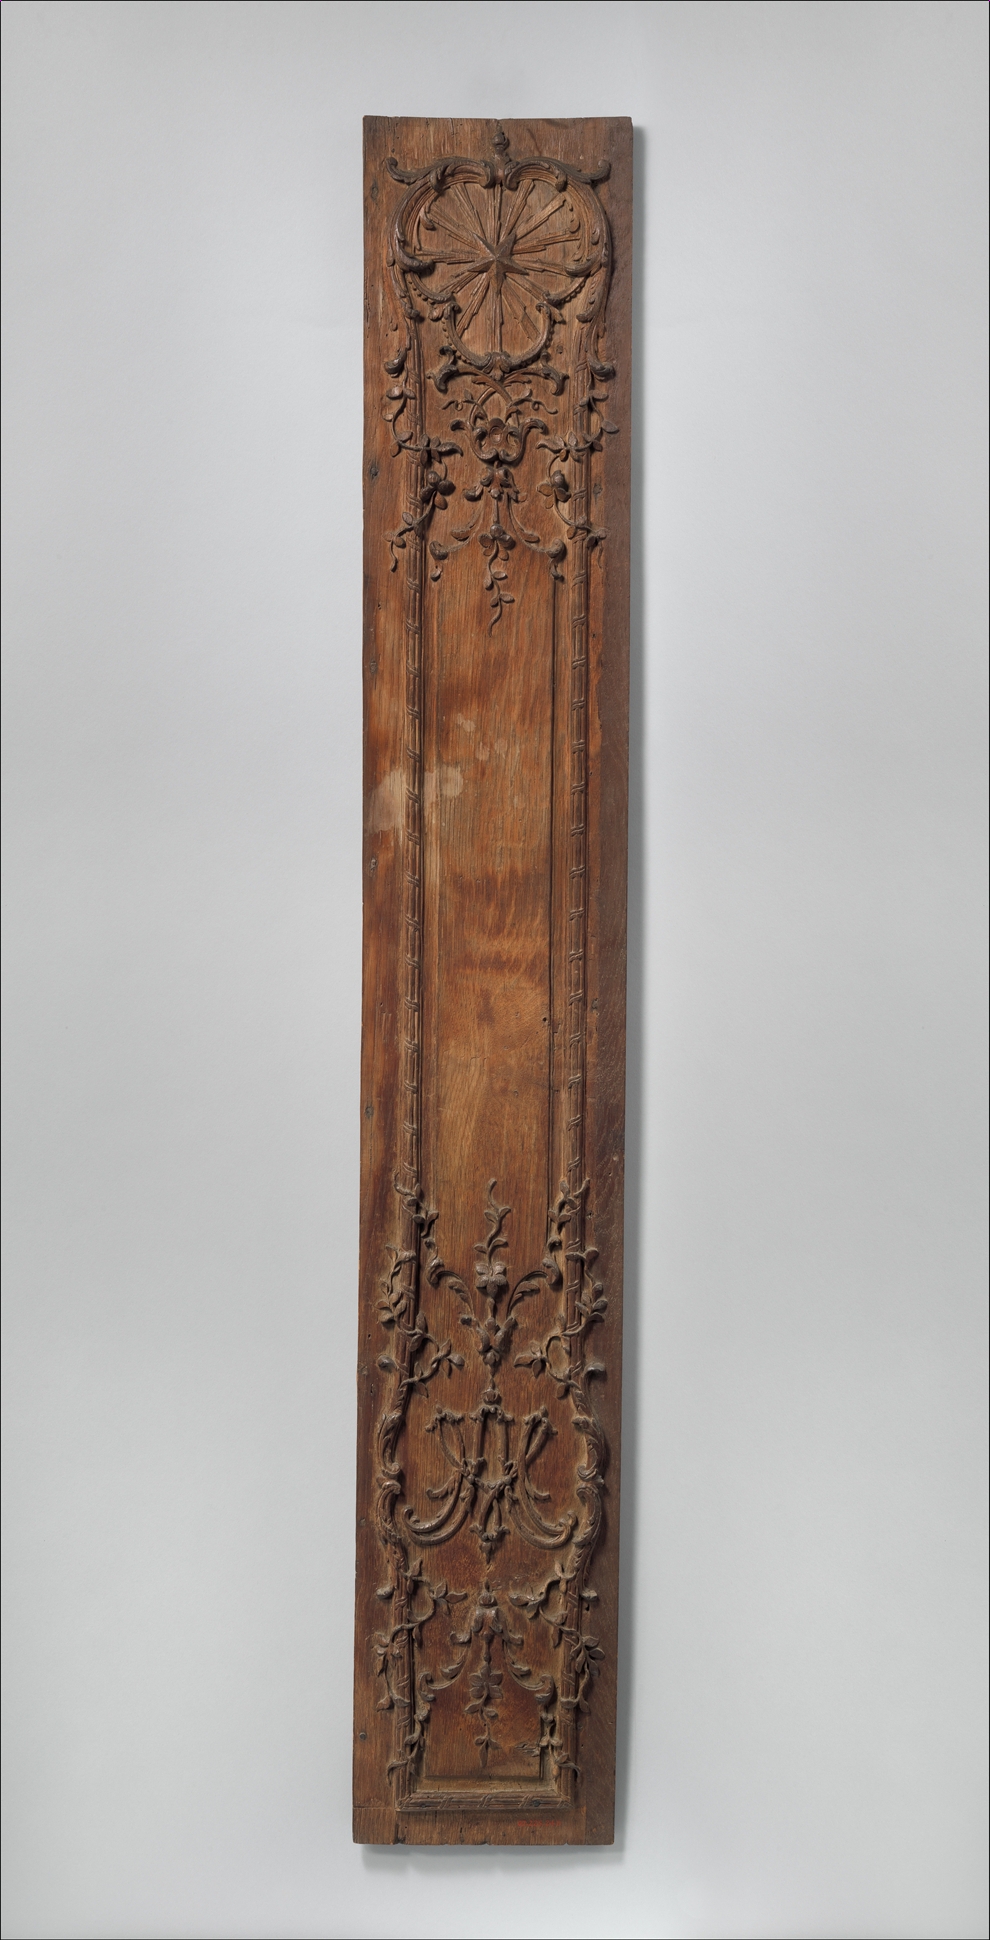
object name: panel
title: Panel (one of a pair)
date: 1730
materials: wood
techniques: carving